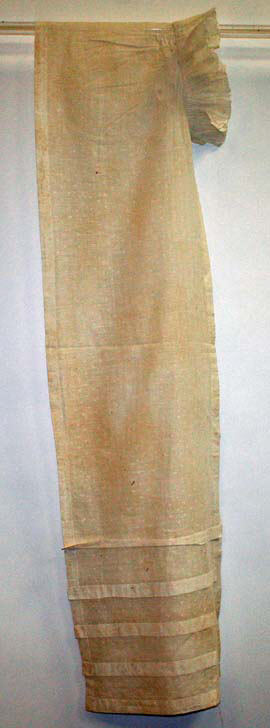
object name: stole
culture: american or european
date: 1810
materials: cotton